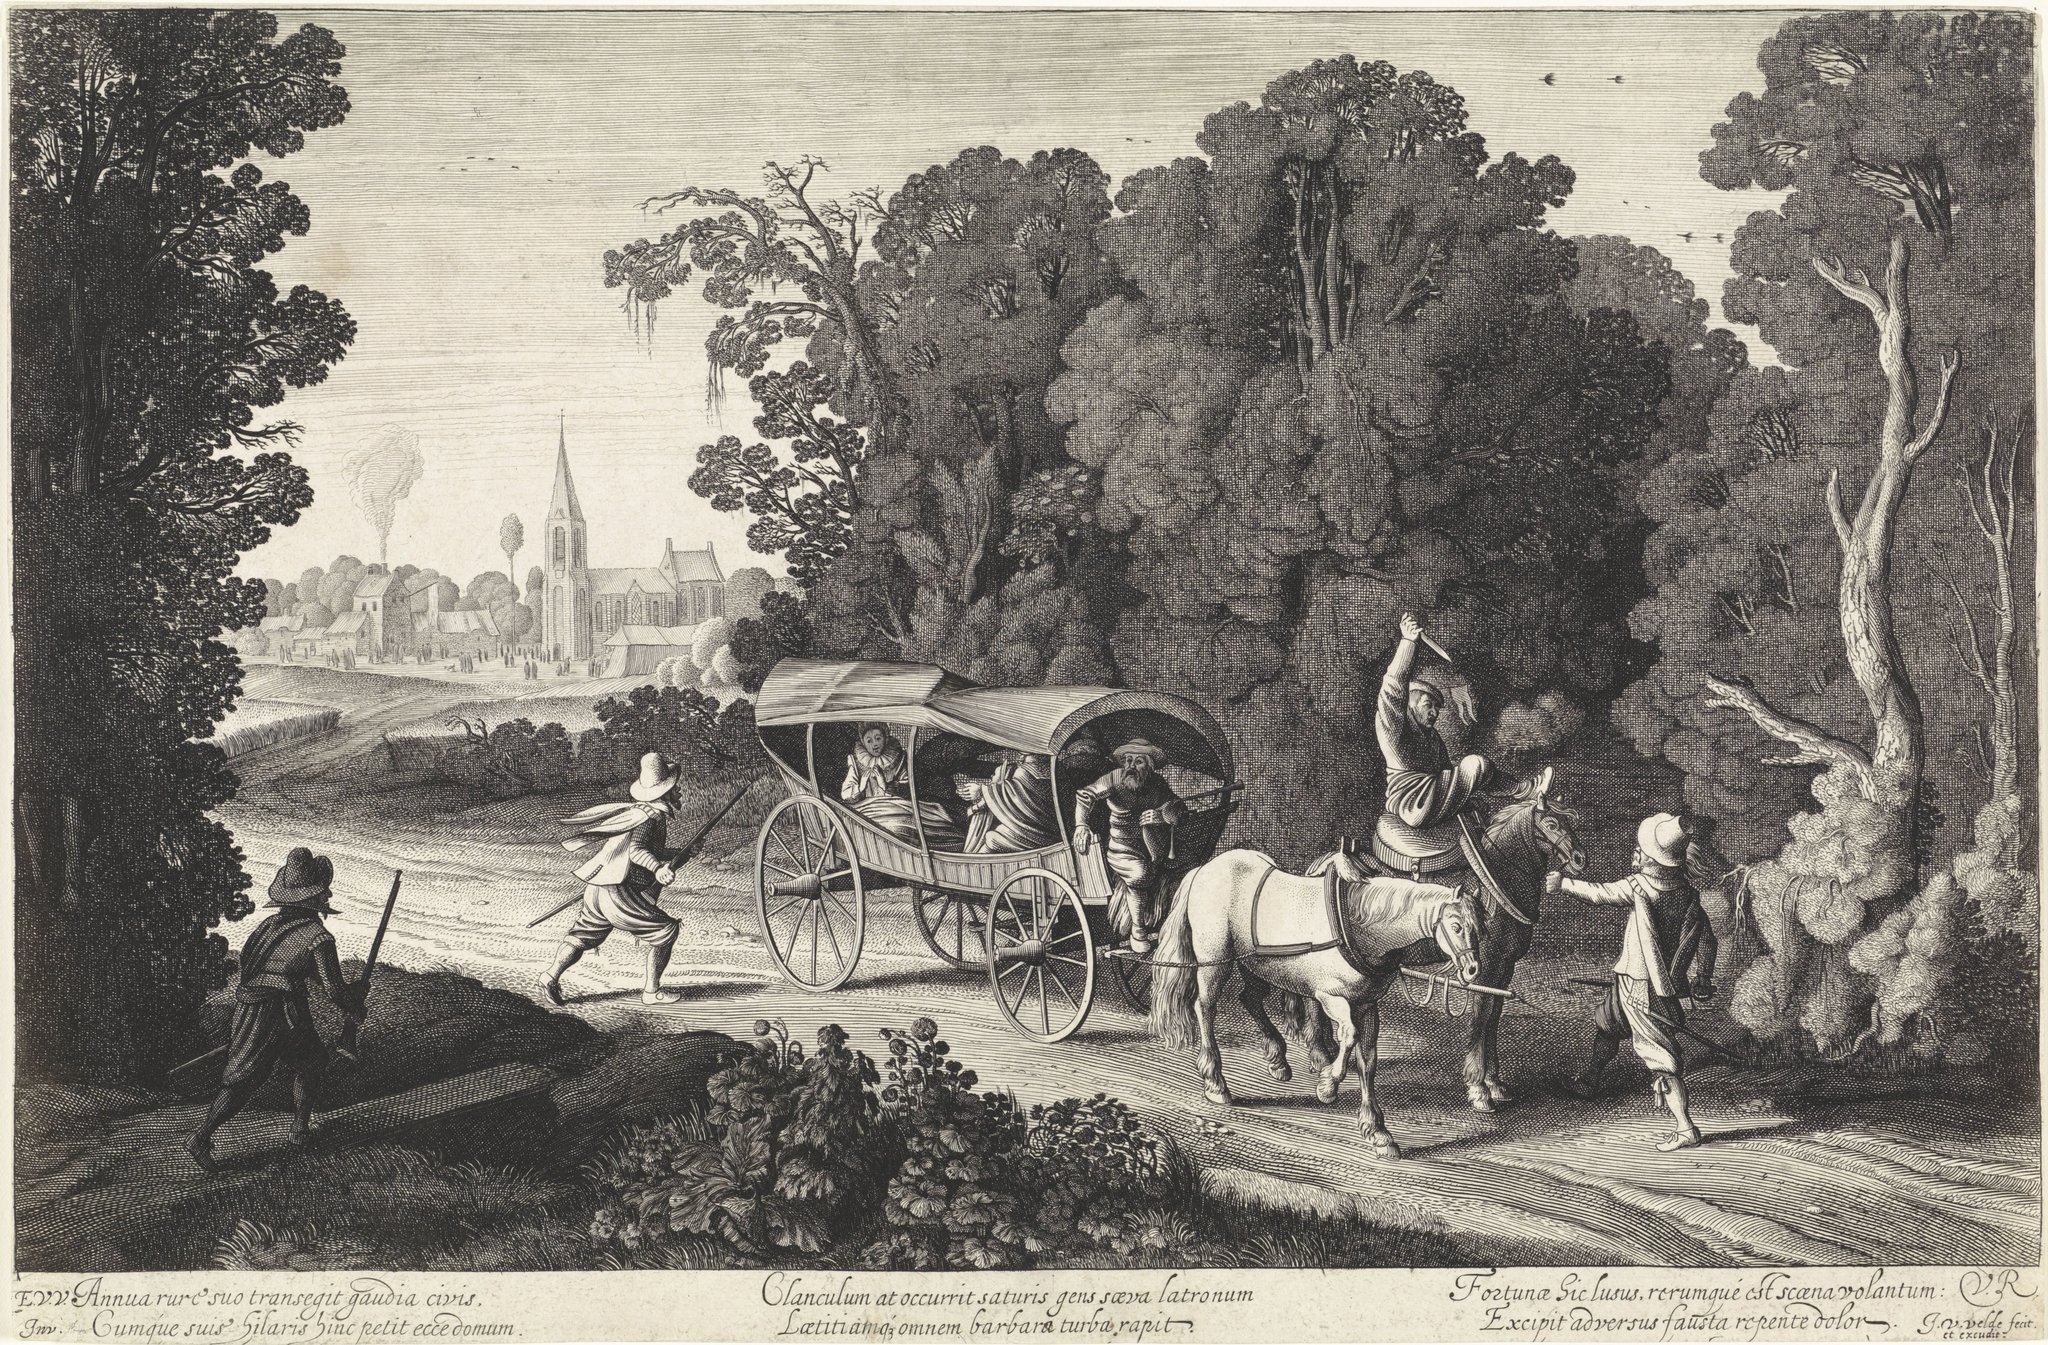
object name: print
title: Overval op een reiswagen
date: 1603-1641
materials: paper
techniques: engraving, etching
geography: northern netherlands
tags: traveller(s) attacked by robber(s), covered wagon, hooded wagon, four-wheeled vehicle drawn by two animals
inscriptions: collector's mark: Lugt 964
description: Een reiswagen waarin verschillende figuren wordt overvallen door drie mannen op een landweg tussen bomen. Op de achtergrond een dorp. De bestuurder van de overkapte wagen, op een van de twee paarden, heft zijn mes.